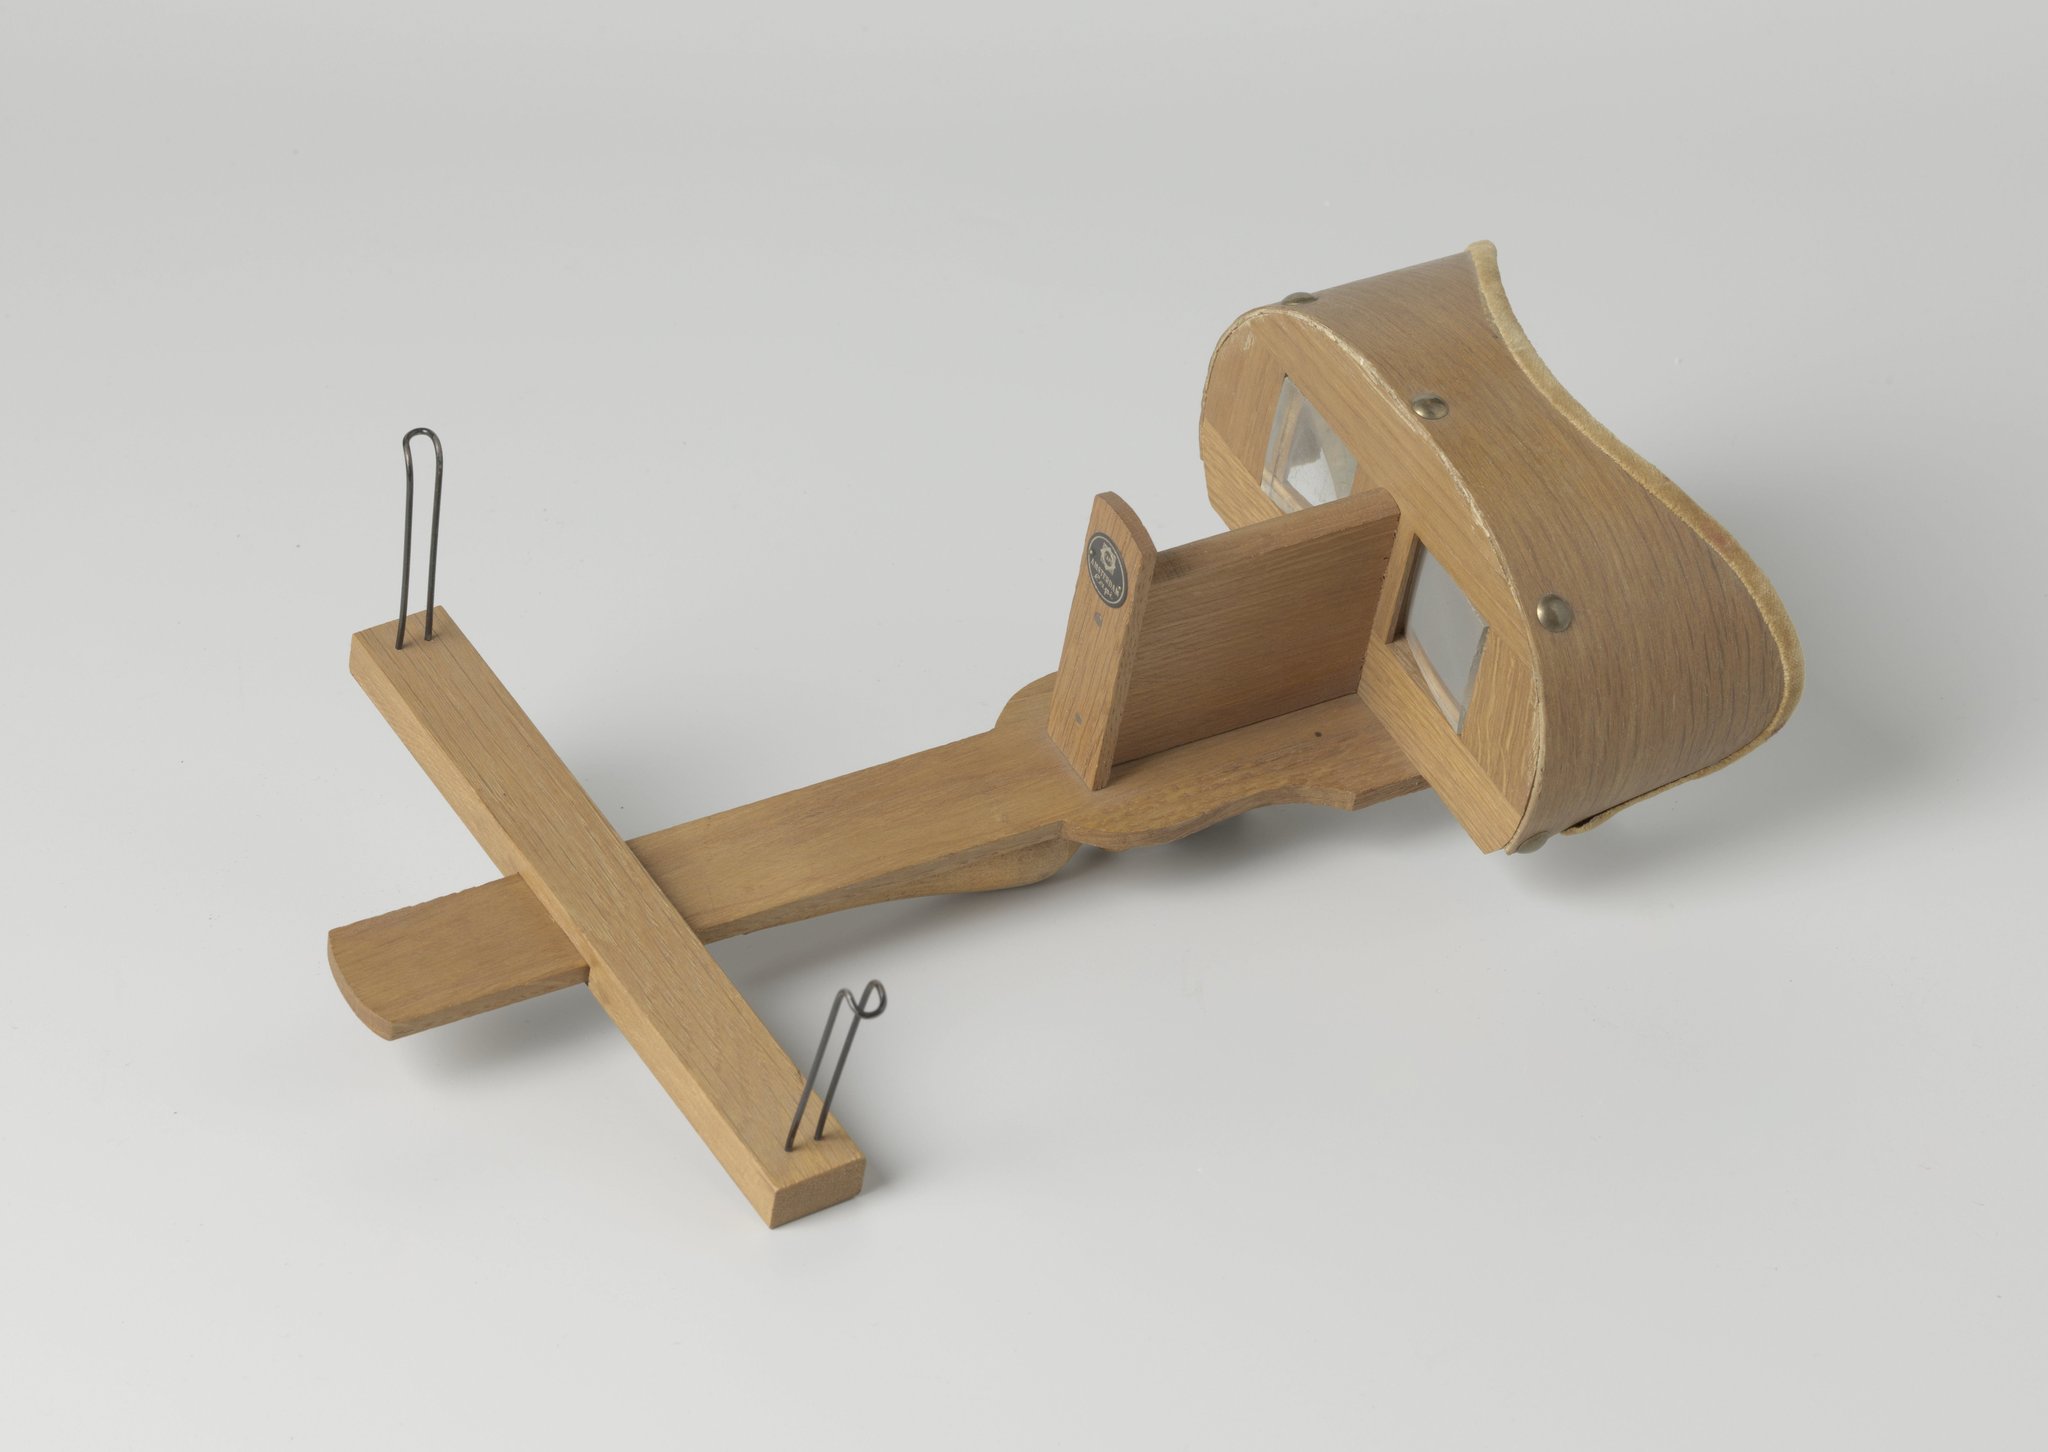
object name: object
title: Stereokijker (type Holmes)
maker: Anonymous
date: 1400-1950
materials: glass, metal, wood